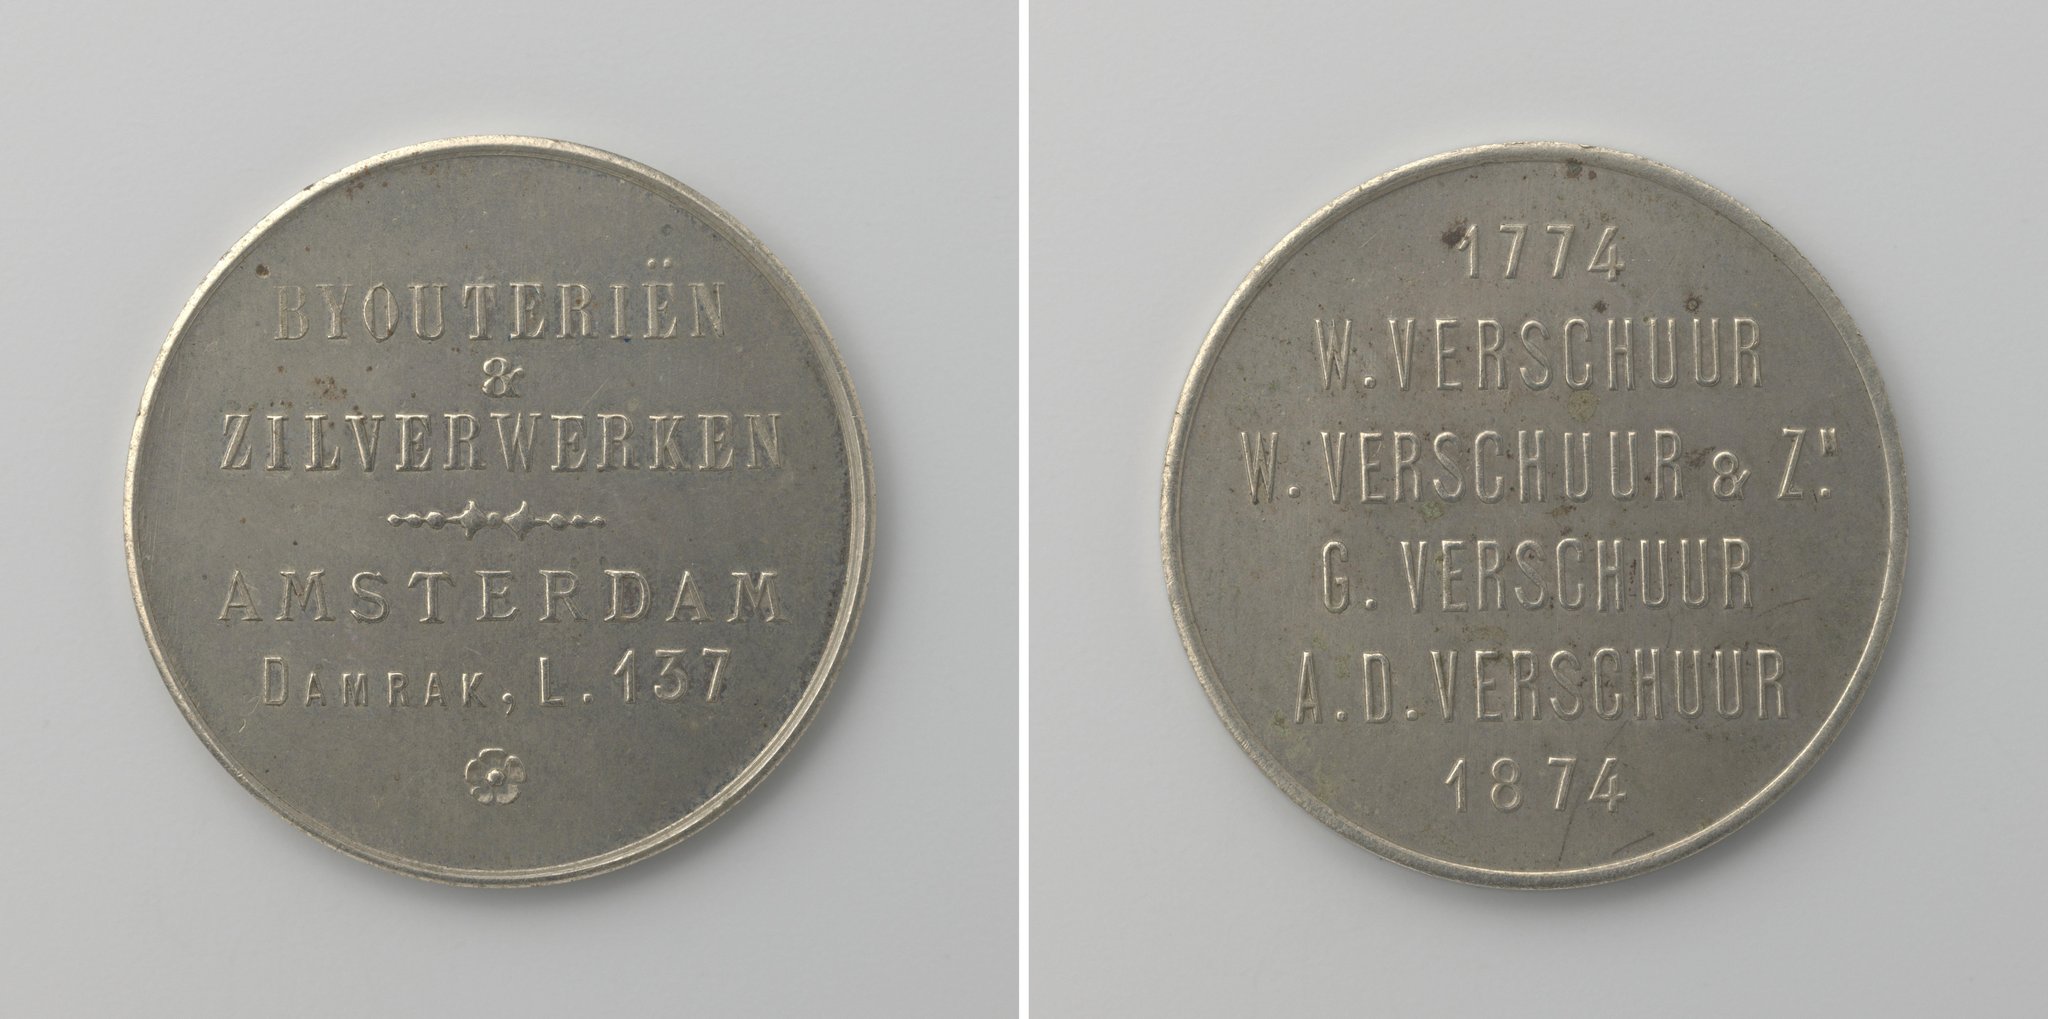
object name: adrespenning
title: Adrespenning van de firma Verschuur te Amsterdam bij het honderdjarig bestaan 1874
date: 1874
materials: metal alloy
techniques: striking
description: Penning van kopernikkel, op de voorzijde vijf regels tekst en een rozet, op de keerzijde zes regels tekst.